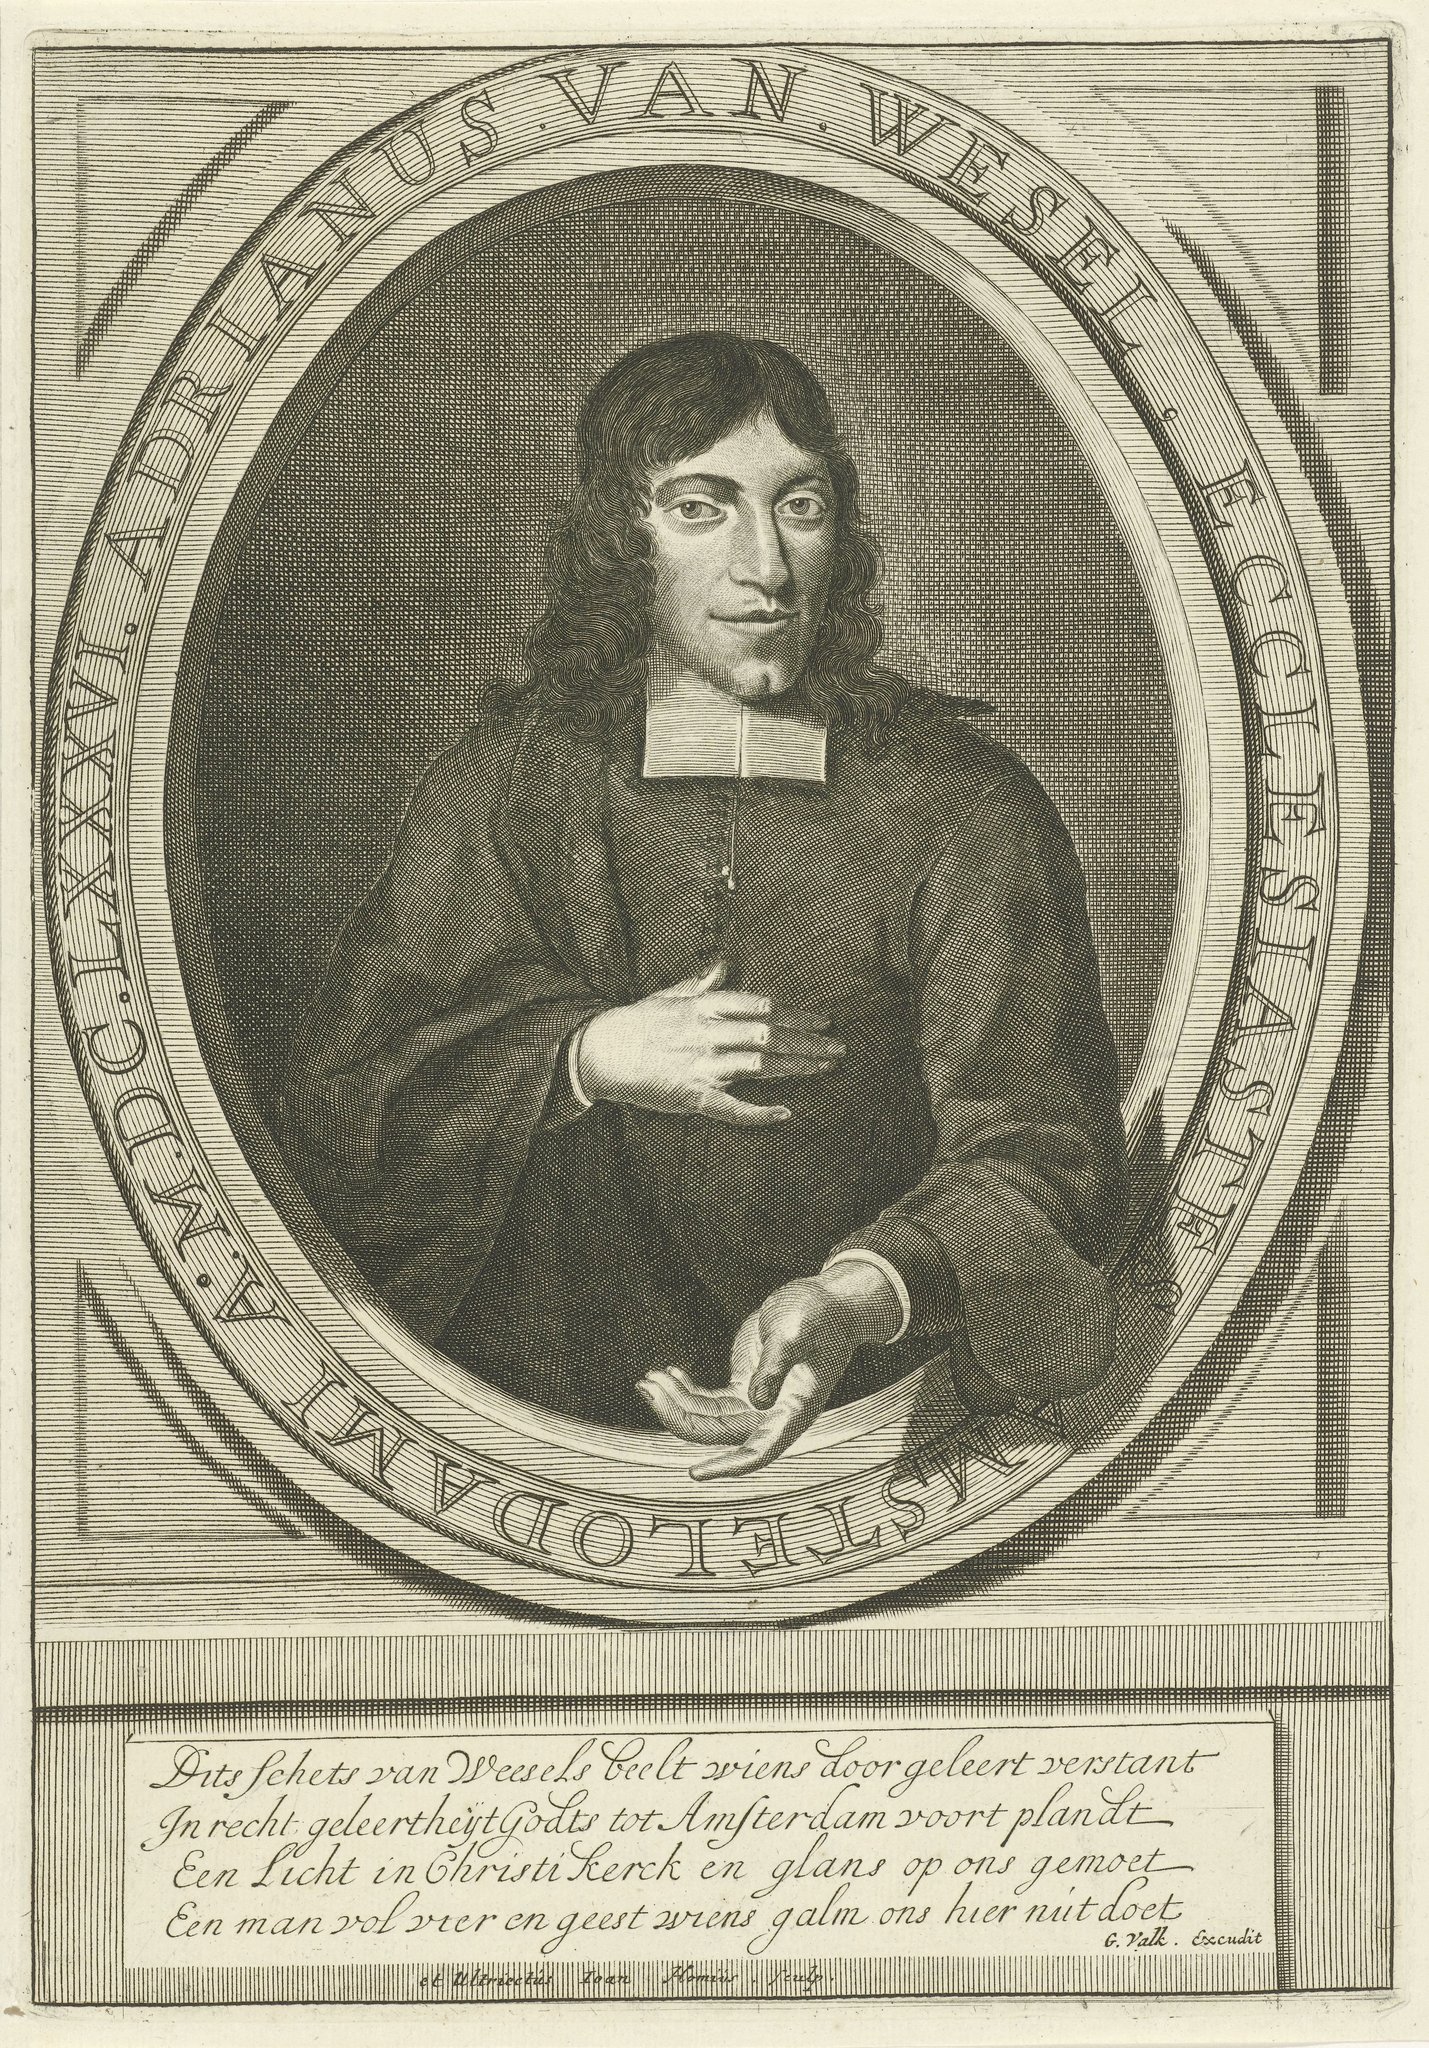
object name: print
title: Portret van Adriaan Wesel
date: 1686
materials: paper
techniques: engraving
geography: amsterdam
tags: predikant, theoloog, adriaan wesel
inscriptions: collector's mark: Lugt 2228, collector's mark: Lugt 2760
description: Portret ten halven lijve van de Amsterdamse predrikant Adriaan Wesel in een ovaal met randschrift in het Latijn. Onder het portret vier regels in het Nederlands.